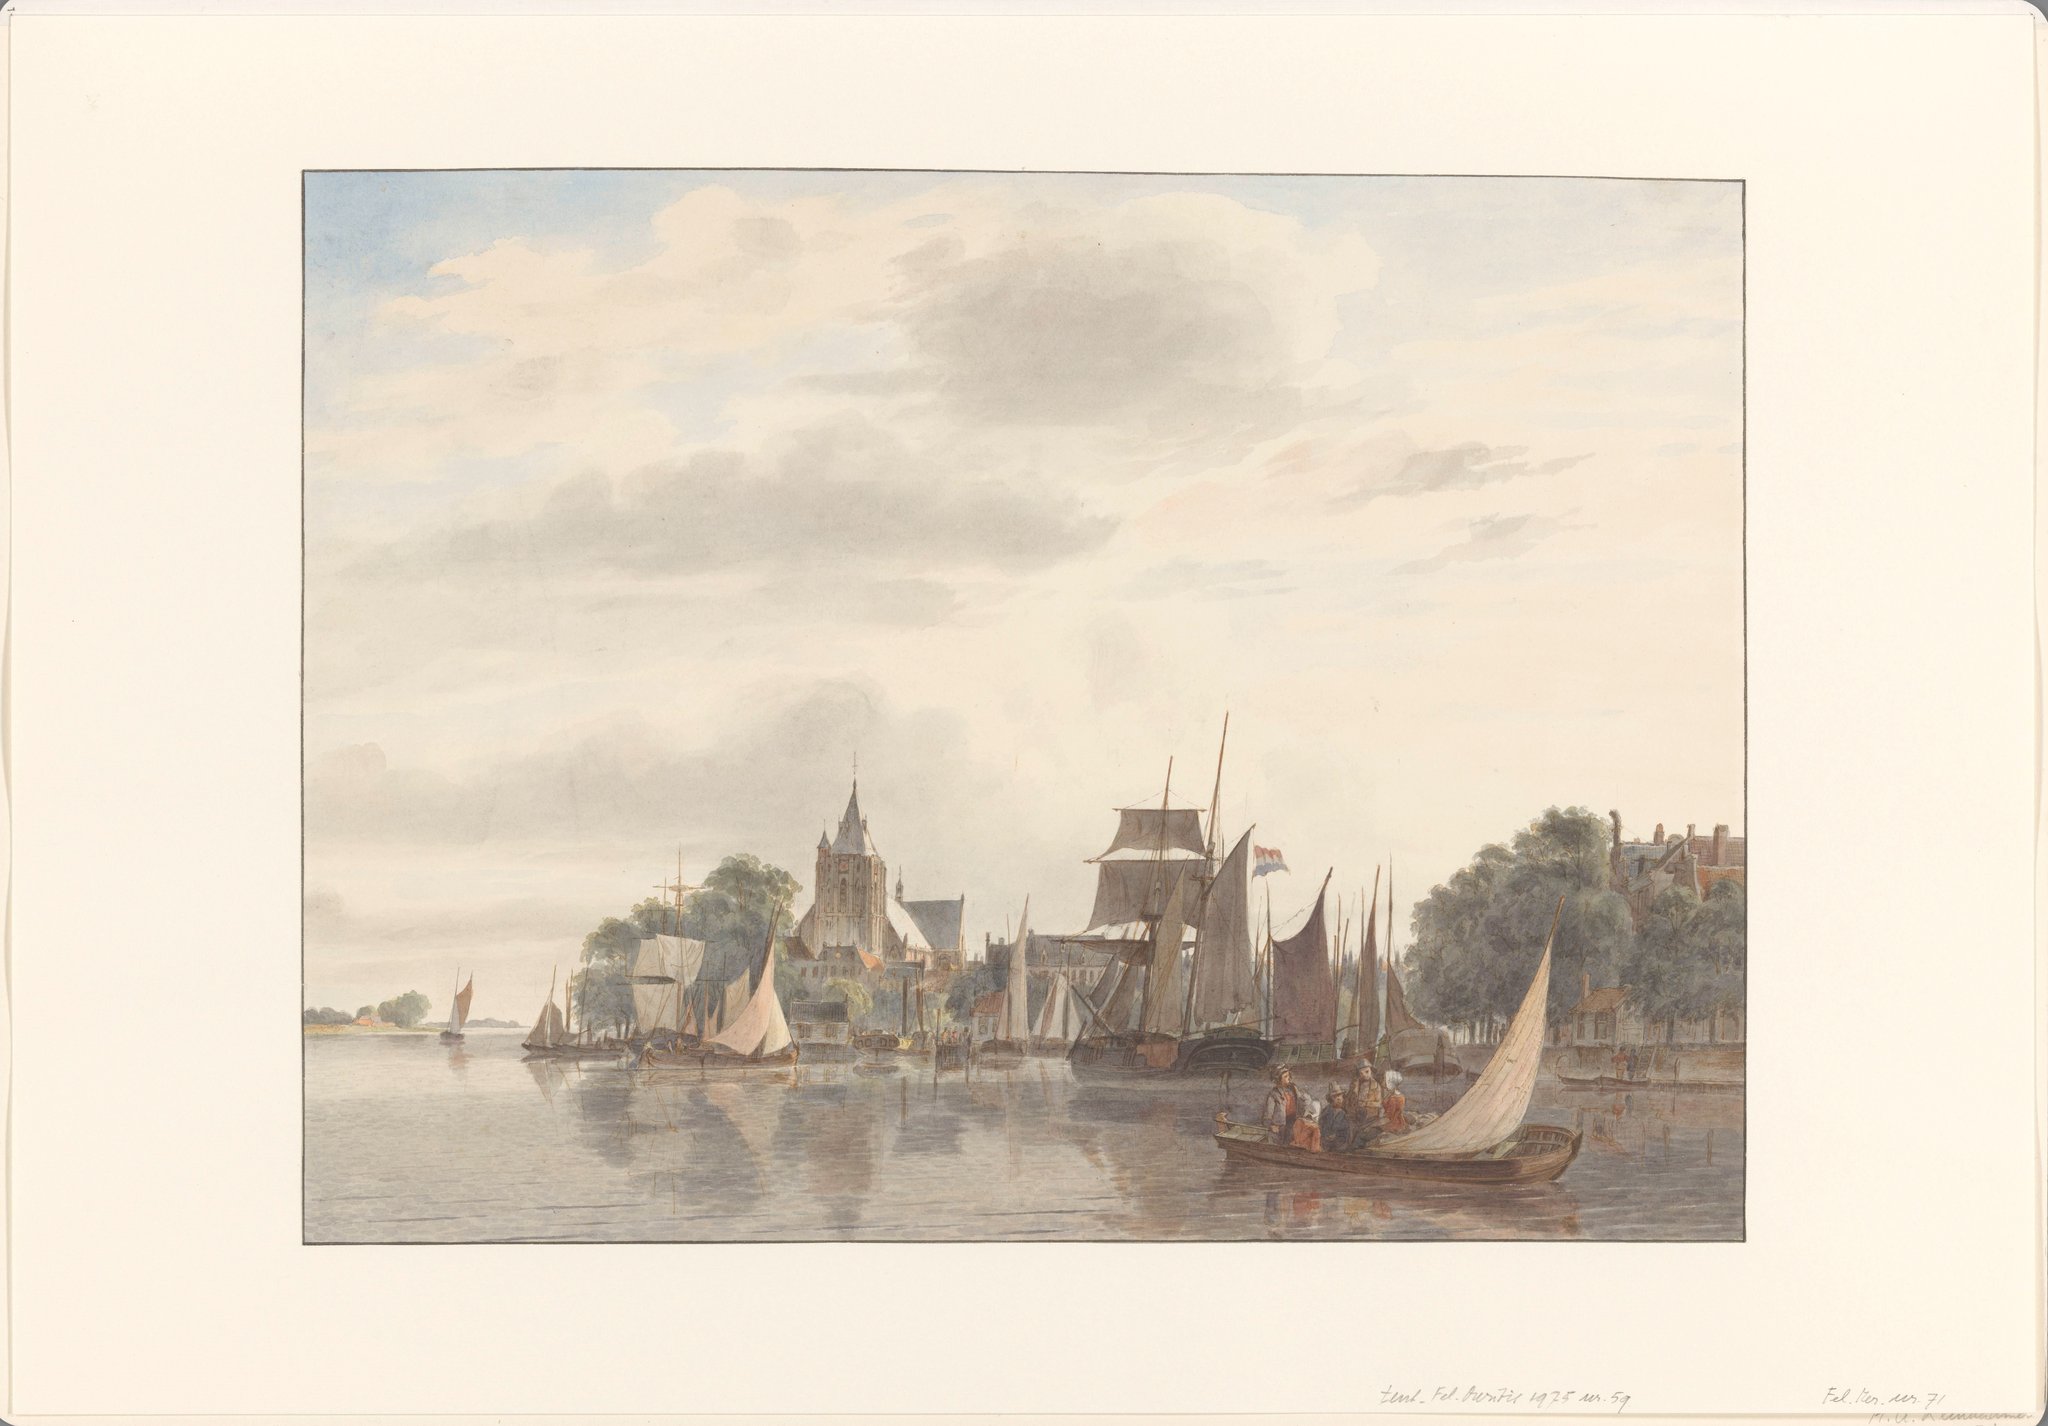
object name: drawing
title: Stad aan het water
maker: hendrik abraham klinkhamer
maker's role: draughtsman, painter, print maker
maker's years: 1810-1872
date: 1845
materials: ink, paper, pencil, watercolor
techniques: brush, pen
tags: river, prospect of city, town panorama, silhouette of city